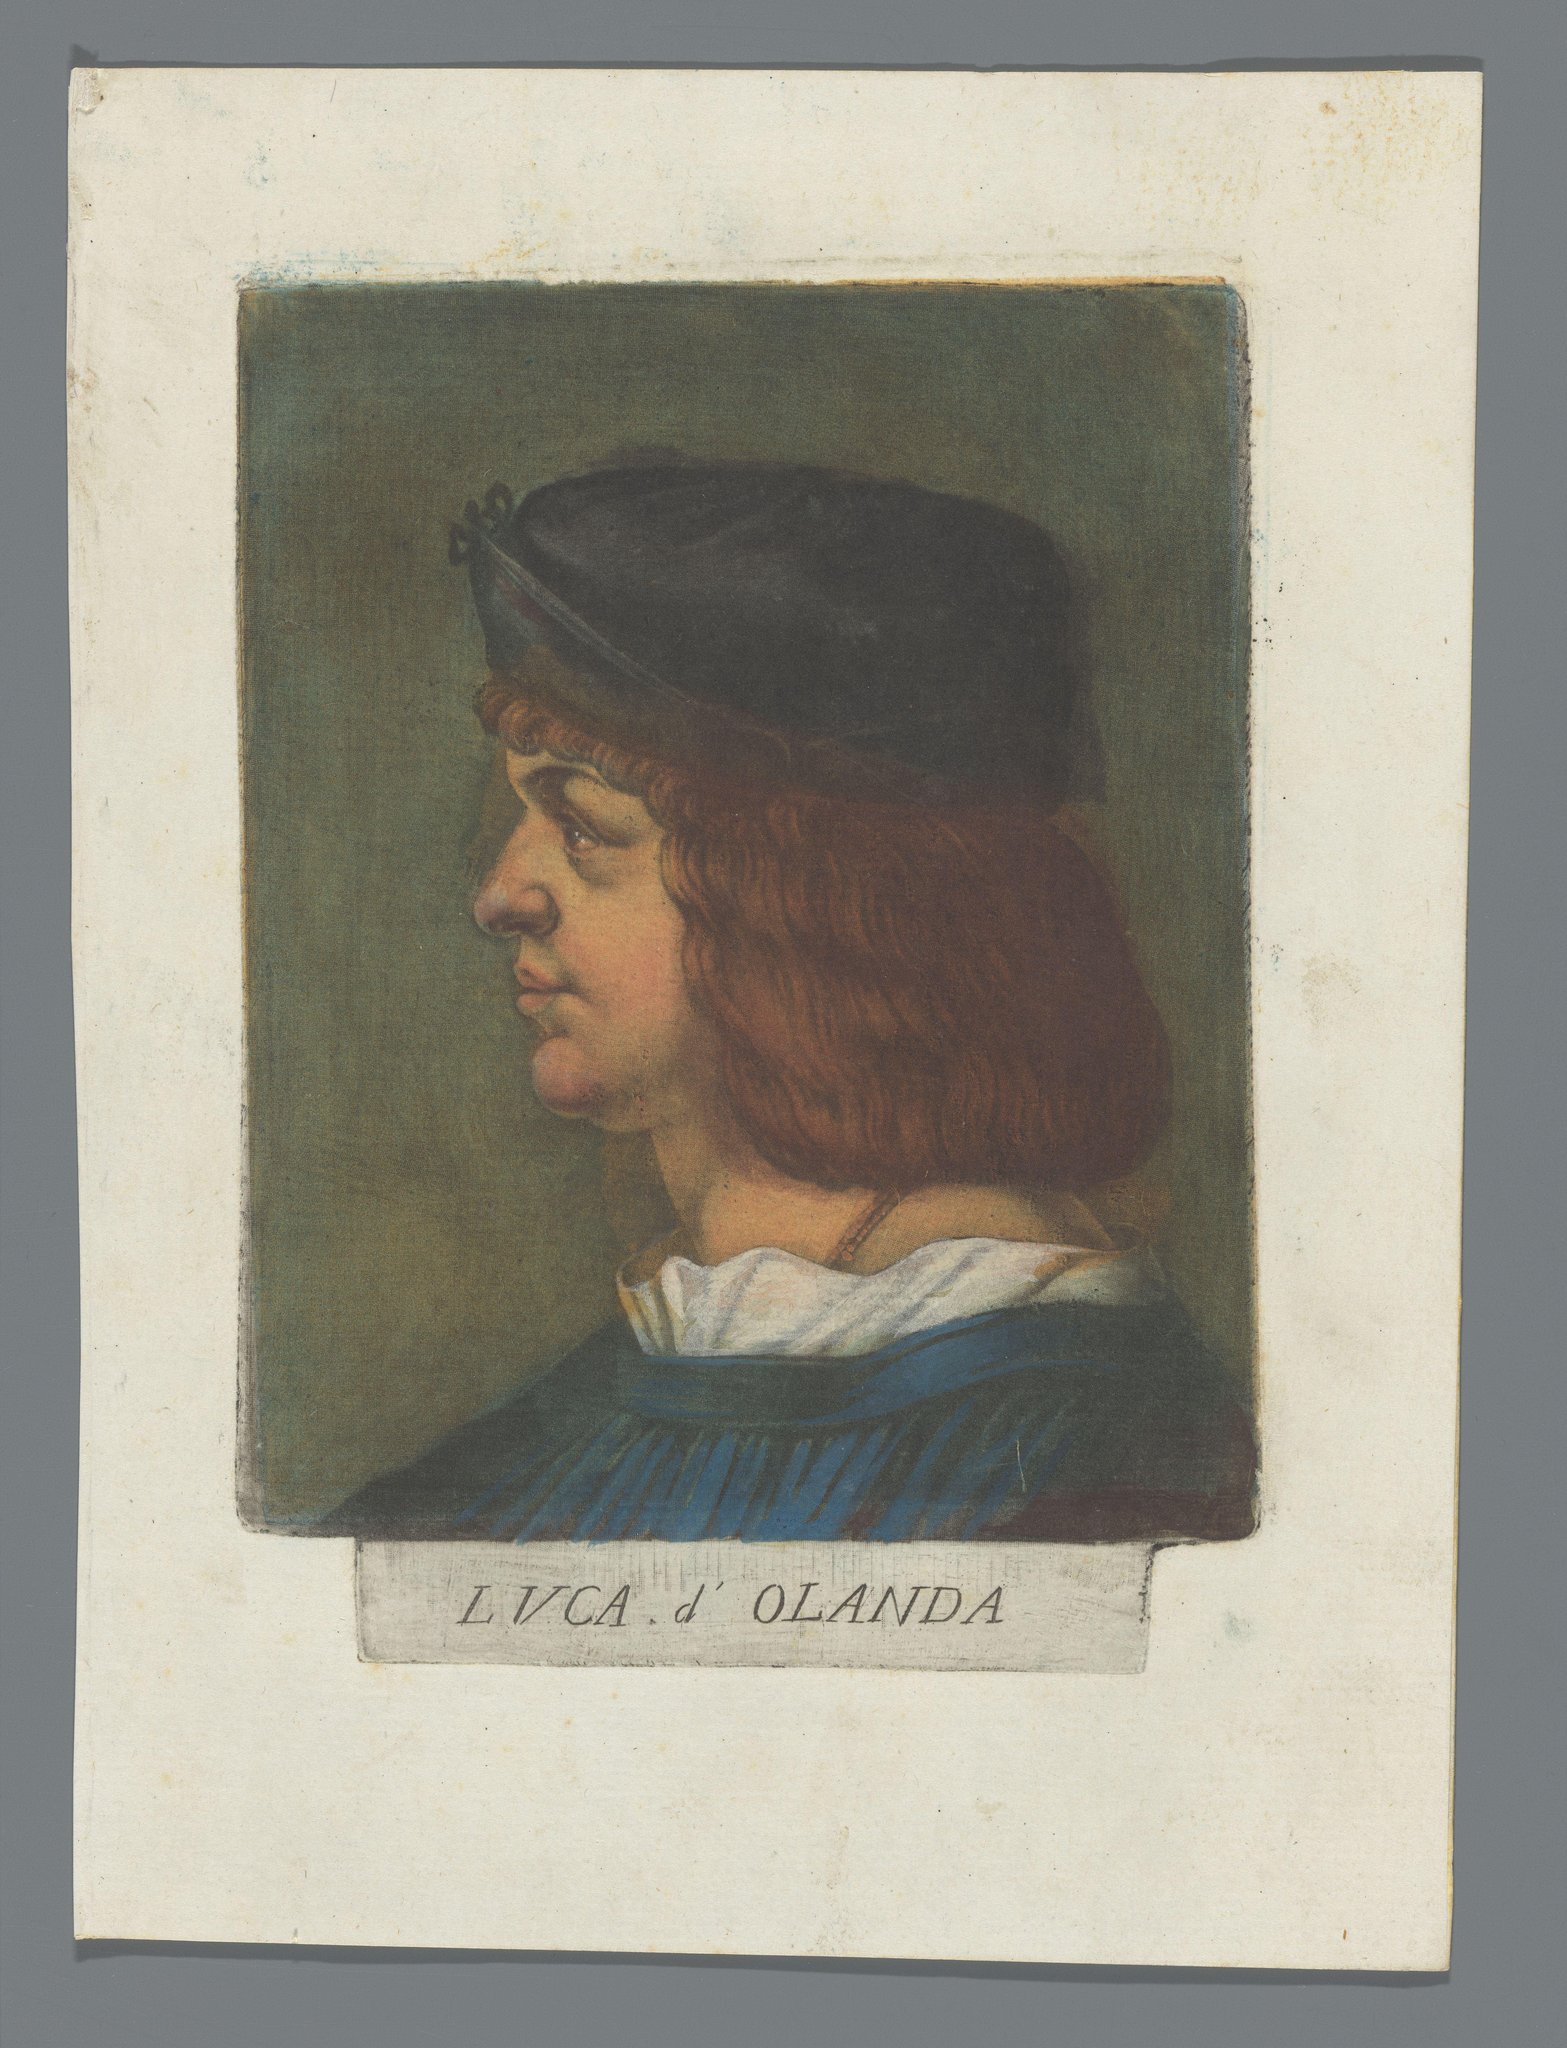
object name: print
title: Portret van Lucas van Leyden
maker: carlo lasinio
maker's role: painter, print maker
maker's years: 1759-1838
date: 1789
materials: gouache, paper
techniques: color mezzotint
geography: florence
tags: leiden, draughtsman, lucas van leyden, historical persons, portrait, self-portrait of painter, portrait, self-portrait of artist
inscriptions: collector's mark: Lugt 2228, inscription:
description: Een prent uit een groep van veertig kleurendrukken met kunstenaarsportretten, gebaseerd op de collectie geschilderde zelfportretten van kunstenaars verzameld door de Medici in Florence. De groep maakt deel uit van het grote werk van Lasinio ‘Gli Autoritratti della Real Galleria di Firenze’, uitgegeven in 1789 met omstreeks 350 kunstenaarsportretten. Van deze uitgave is tot nog toe is geen compleet exemplaar bekend. In de inspringende marges onderaan de prenten zijn de namen van de kunstenaars aangebracht en soms hun levensdata en de plaats van geboorte en sterven en een enkele maal de signatuur van Lasinio en dat van de drukker Labrelis. Getuige de bindgaatjes en lijmresten moeten de prenten ingebonden zijn geweest in een album. De meeste prenten zijn verso voorzien van nummers in potlood, met als laagste nummer 2 en hoogste 93. Tevens zijn er verso Italiaanse opschriften in pen aangebracht met de levensdata van de kunstenaars en de school waartoe zij worden gerekend. Deze opschriften zijn vrijwel alle deels afgesneden. Elf prenten zijn niet genummerd en niet voorzien van opschriften. Deze laatste elf zijn alle gedrukt op blauw papier.